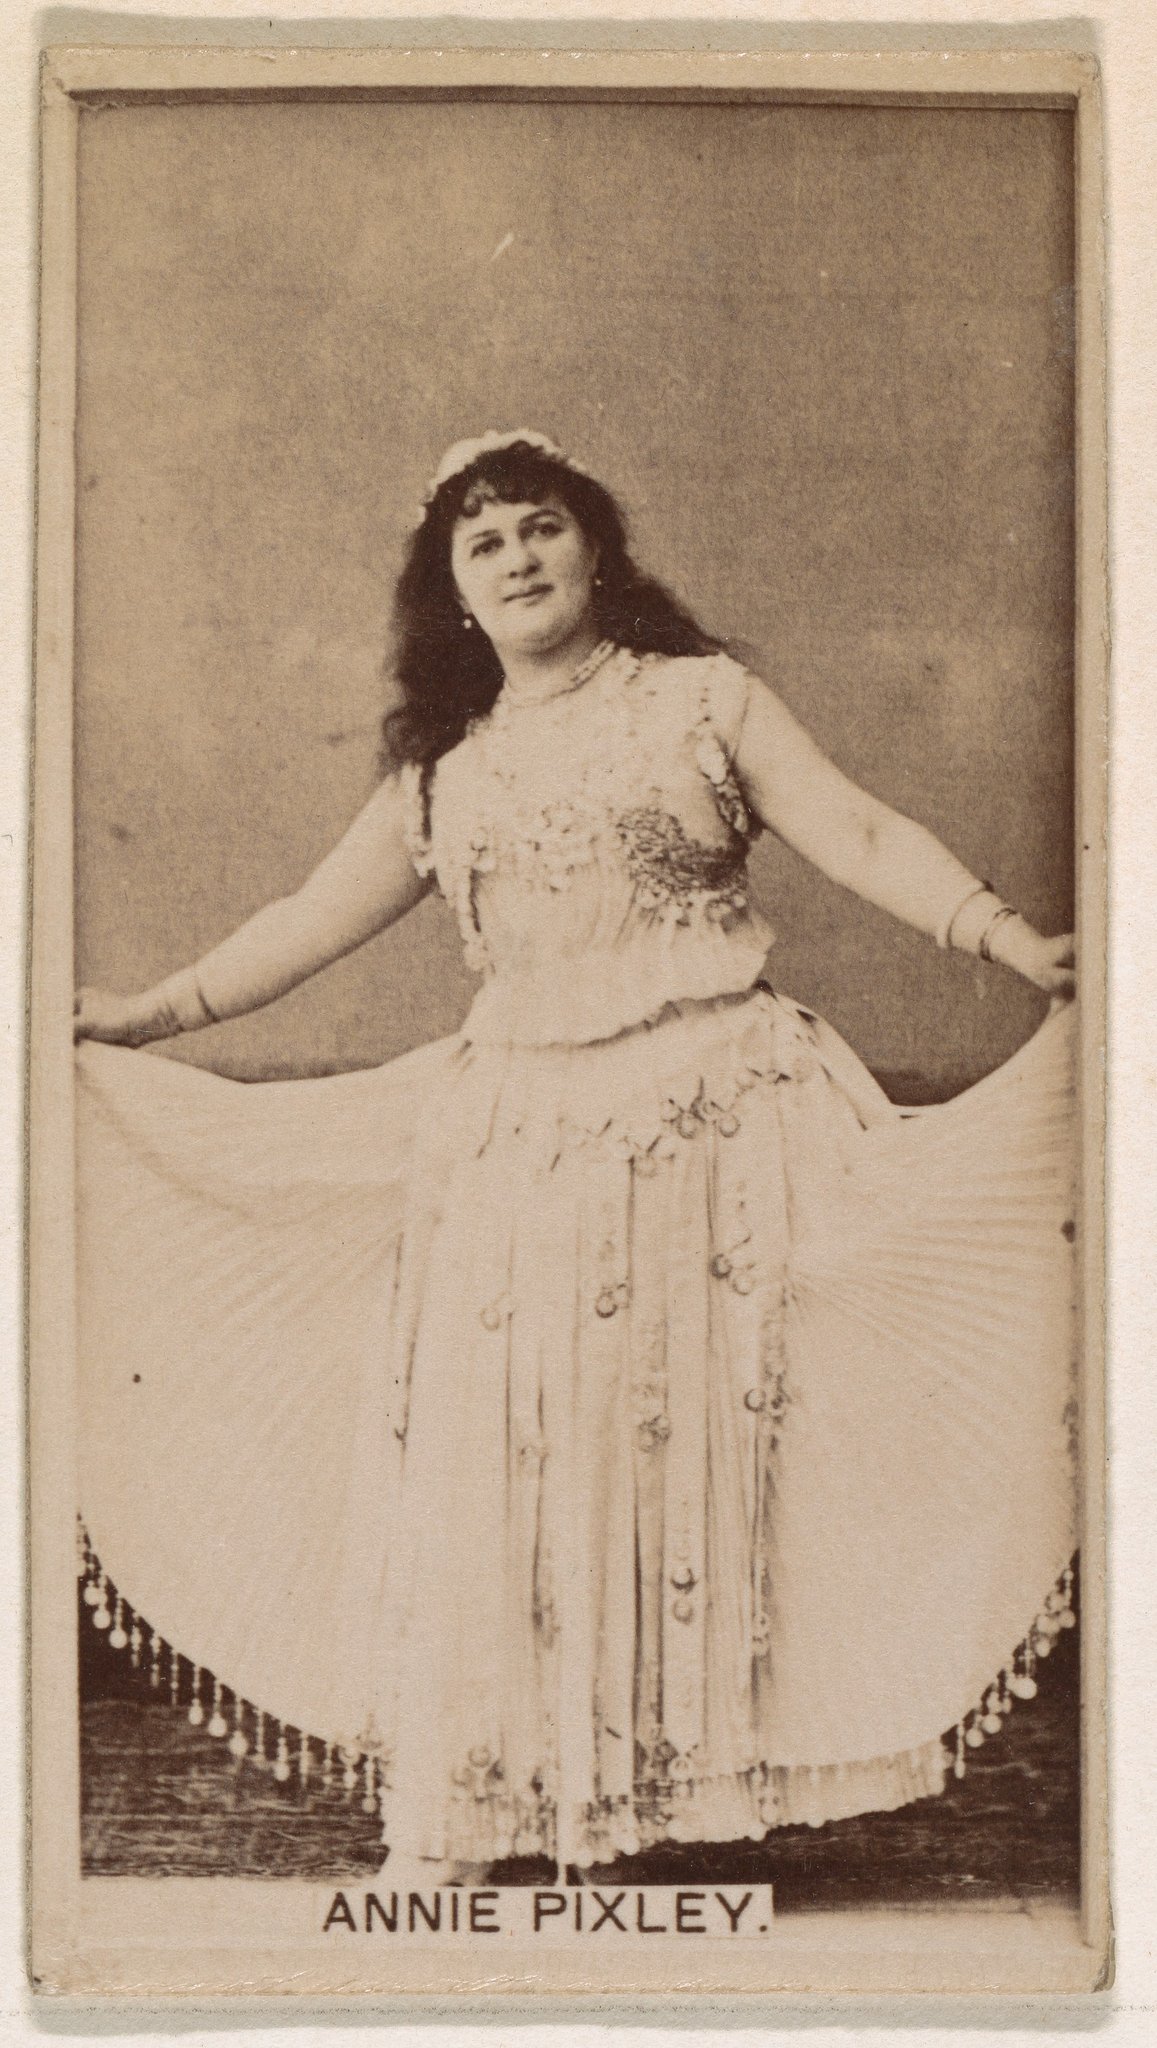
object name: photograph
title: Annie Pixley, from the Actresses series (N245) issued by Kinney Brothers to promote Sweet Caporal Cigarettes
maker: kinney brothers tobacco company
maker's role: publisher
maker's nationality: american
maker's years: 1869-2011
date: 1890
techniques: albumen silver print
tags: portraits,women,actresses